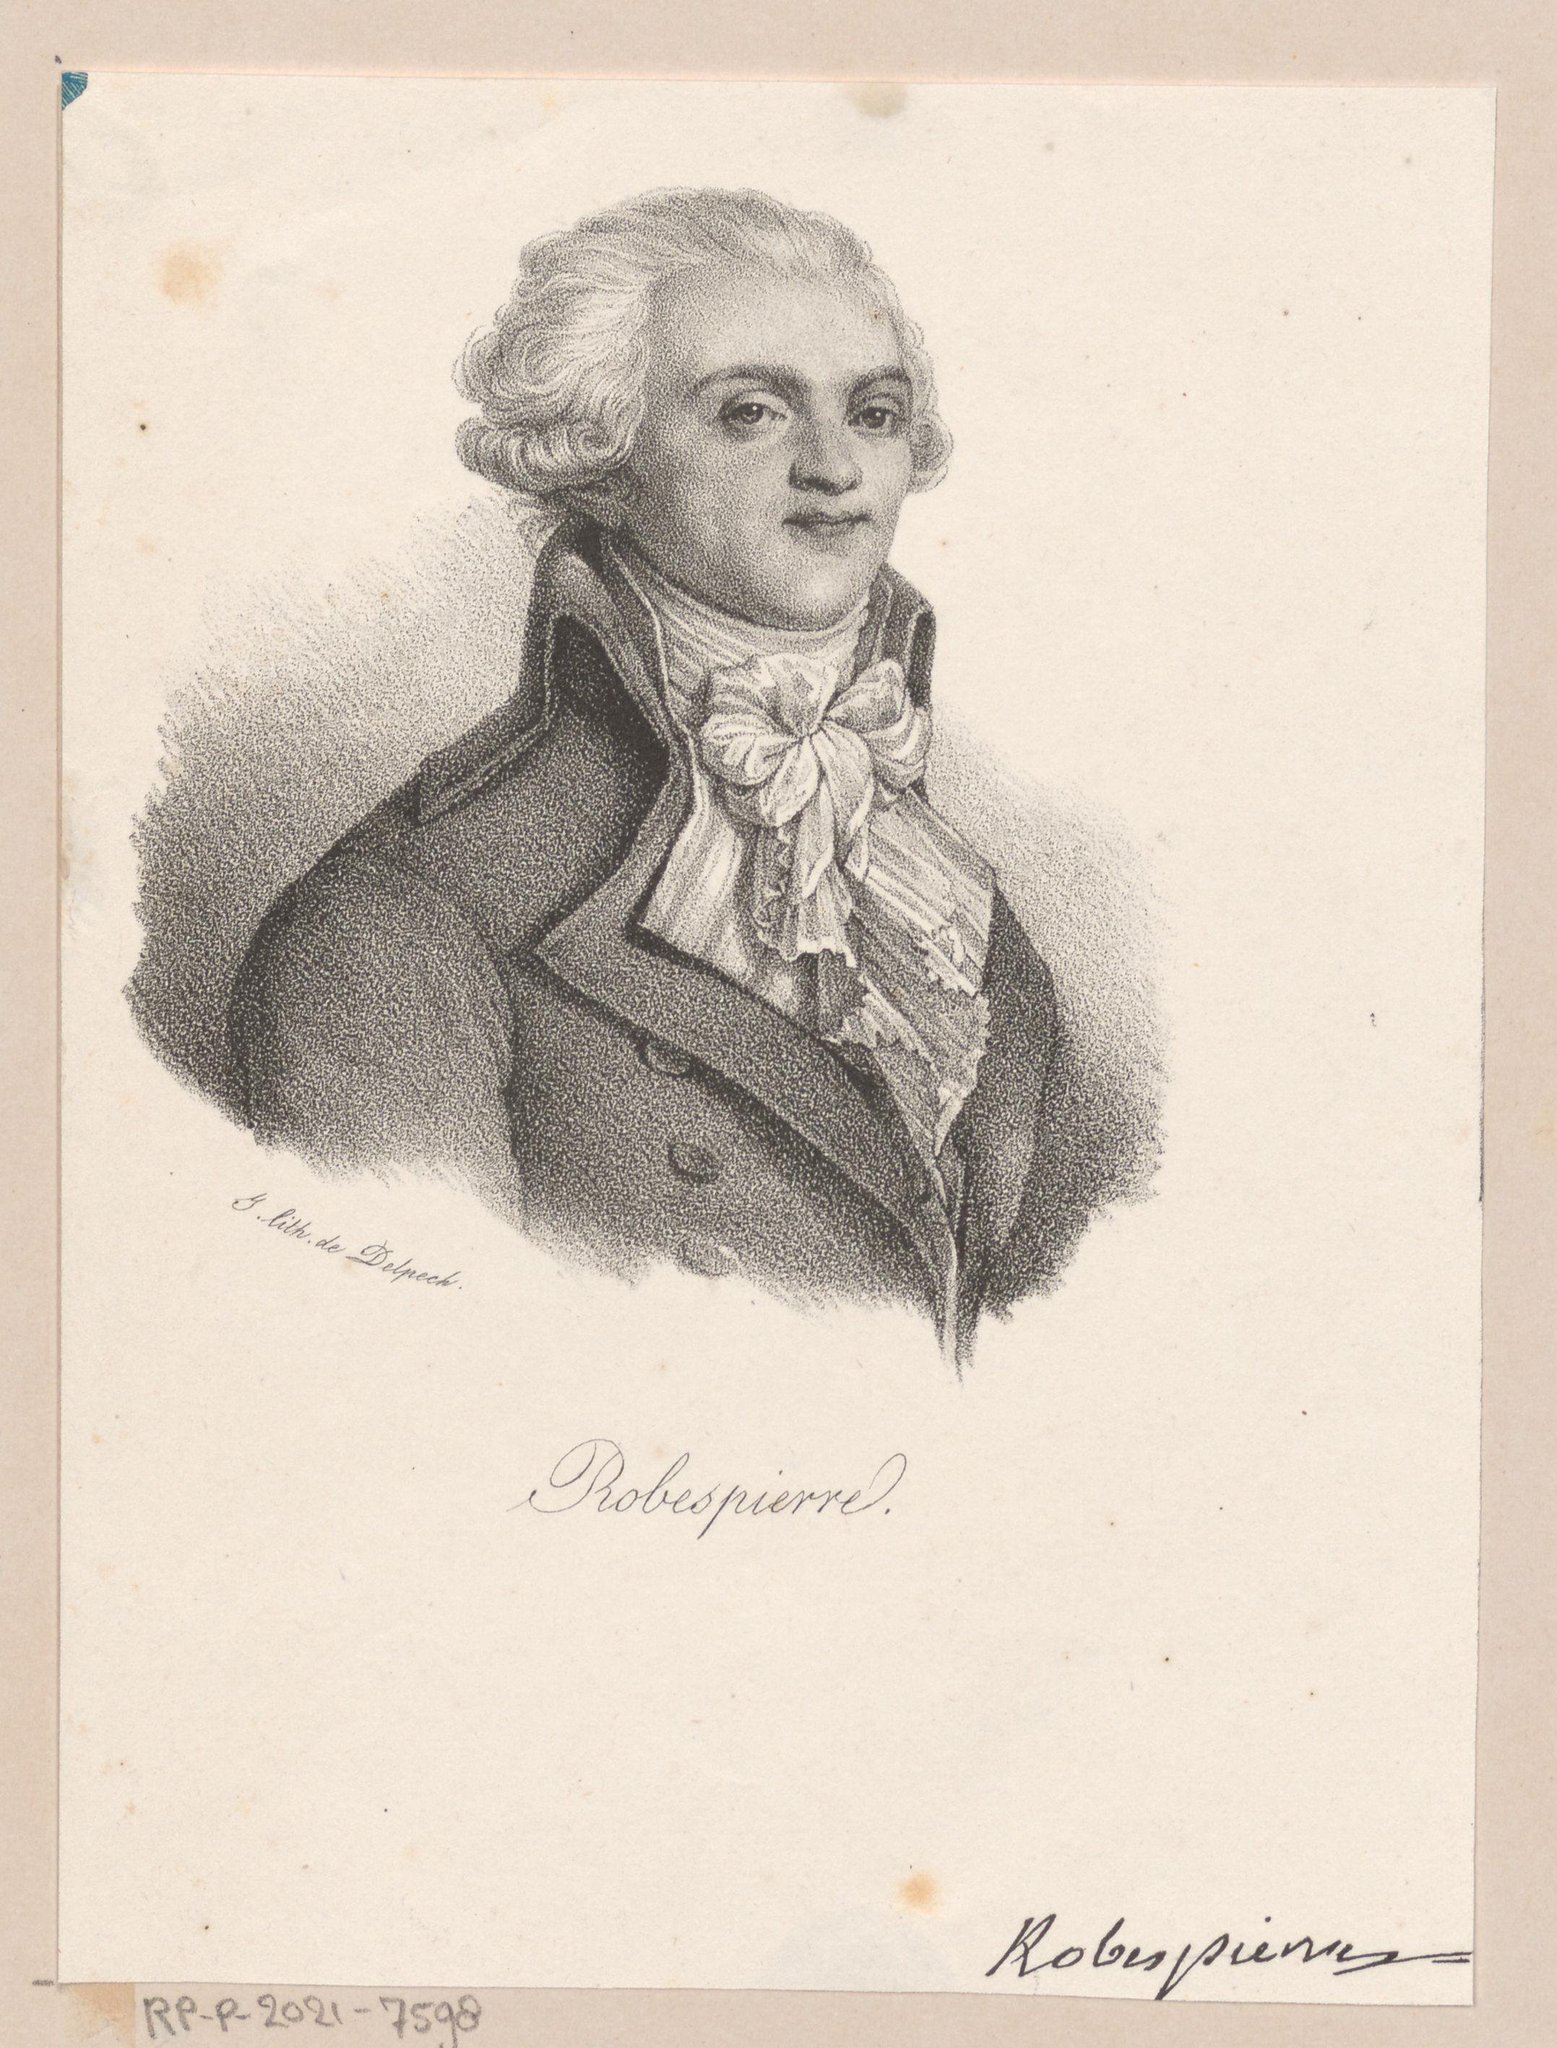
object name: print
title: Portret van Maximilien-Marie-Isidore de Robespierre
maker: Anonymous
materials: paper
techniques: lithograph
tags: paris, historical persons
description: Prent mogelijk uit: Fay, Félix Conny de la. Histoire de la Révolution de France. 9 dln. Parijs: Paul Méquignon, 1834-1842.